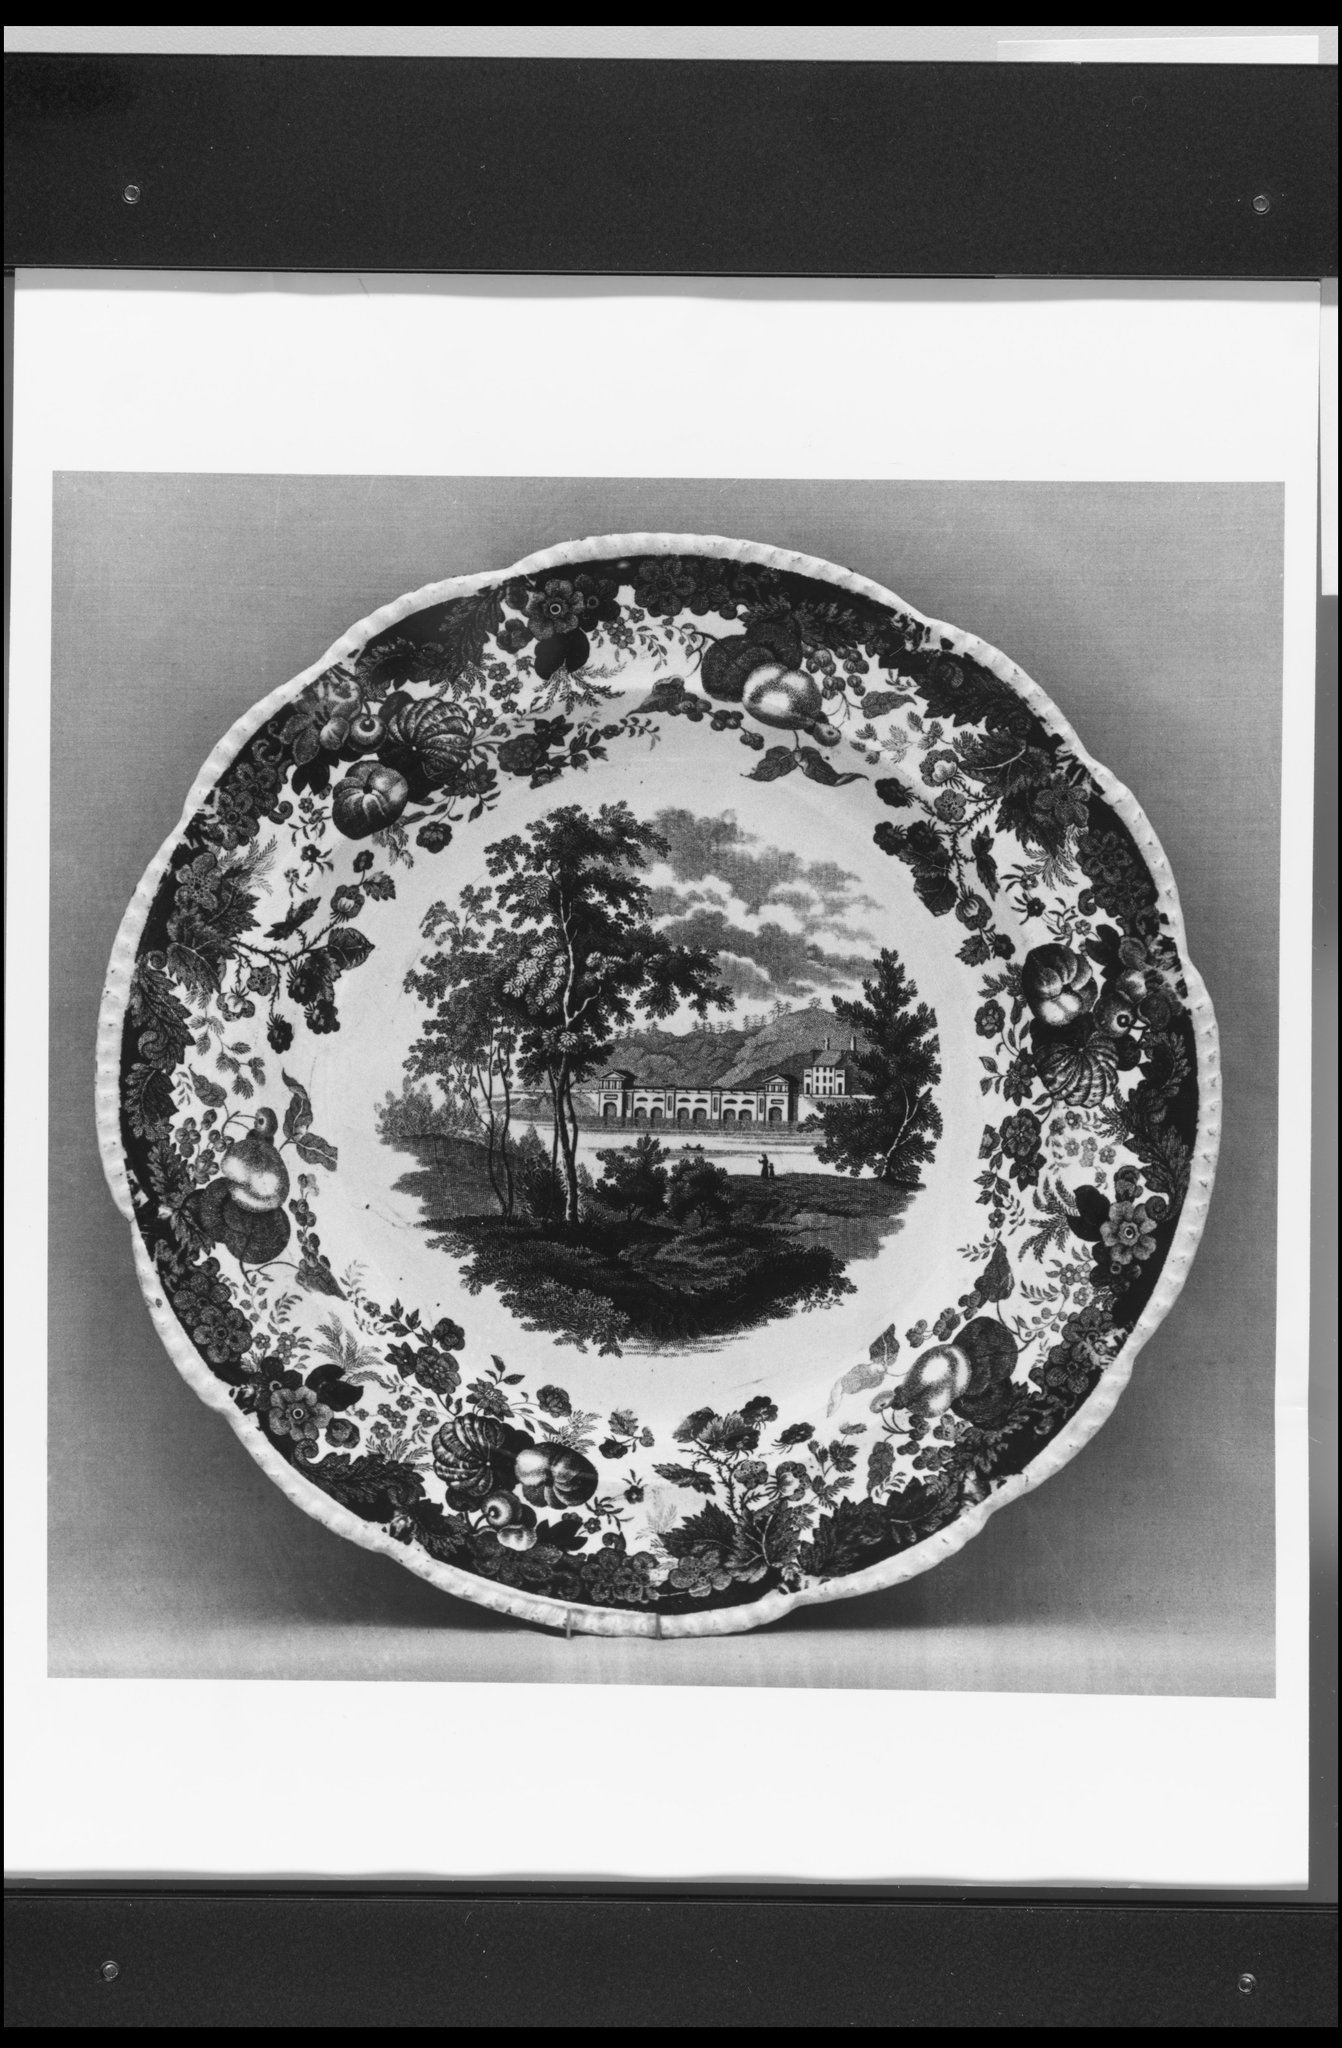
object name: plate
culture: british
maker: enoch wood & sons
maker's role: maker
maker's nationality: british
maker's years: 1818-1846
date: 1824-1846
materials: earthenware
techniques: transfer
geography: england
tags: flowers,landscapes